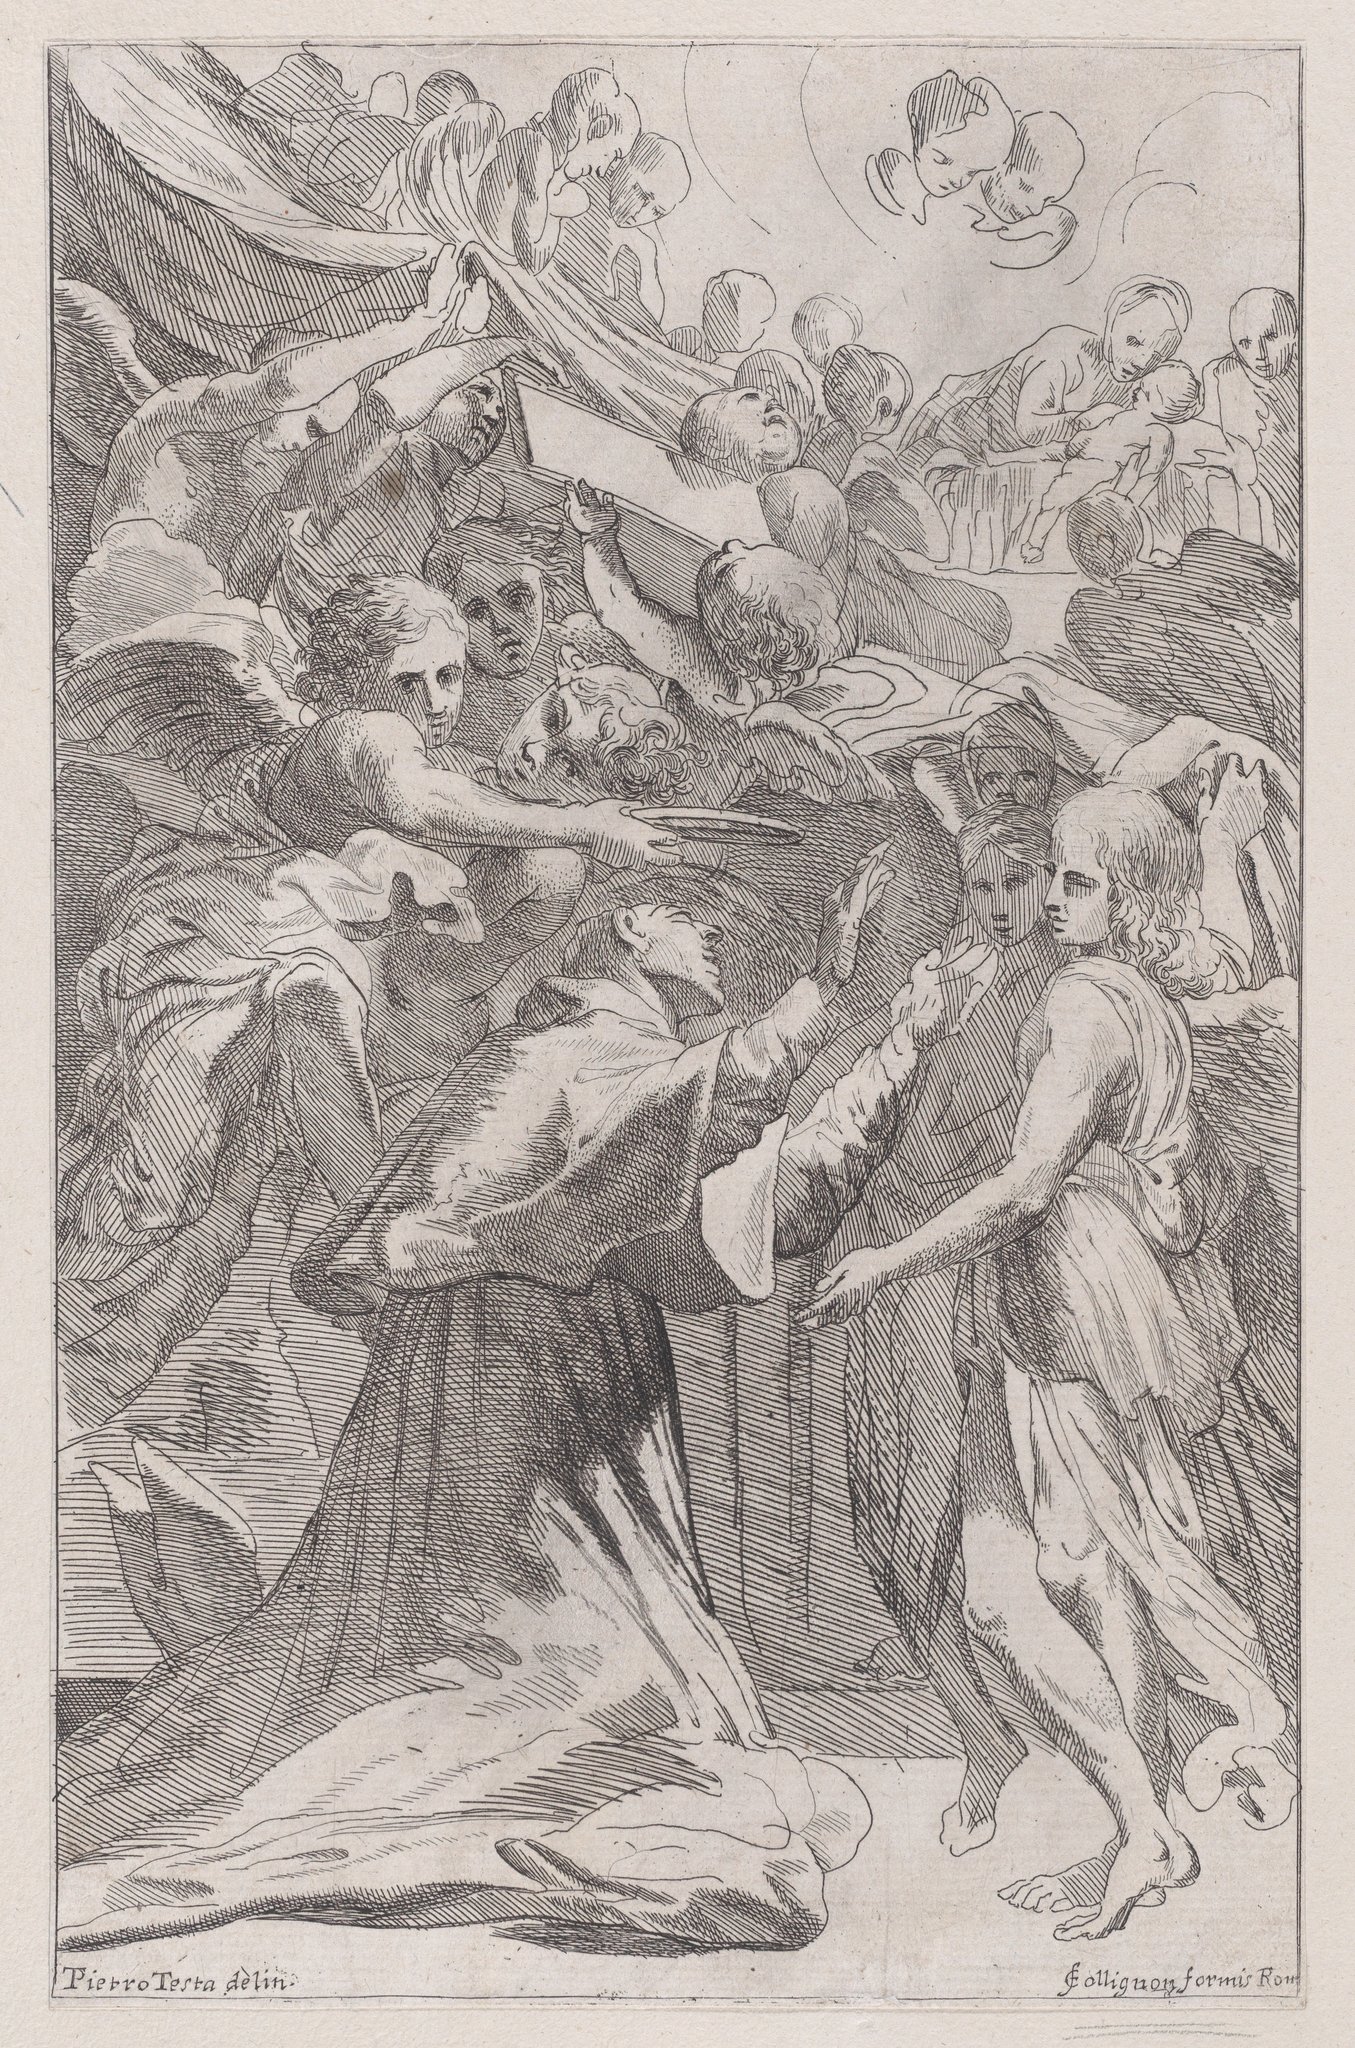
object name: print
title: St. Carlo Borromeo surrounded by angels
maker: pietro testa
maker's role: artist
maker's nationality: italian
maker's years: 1612-1650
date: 1650-1670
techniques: etching